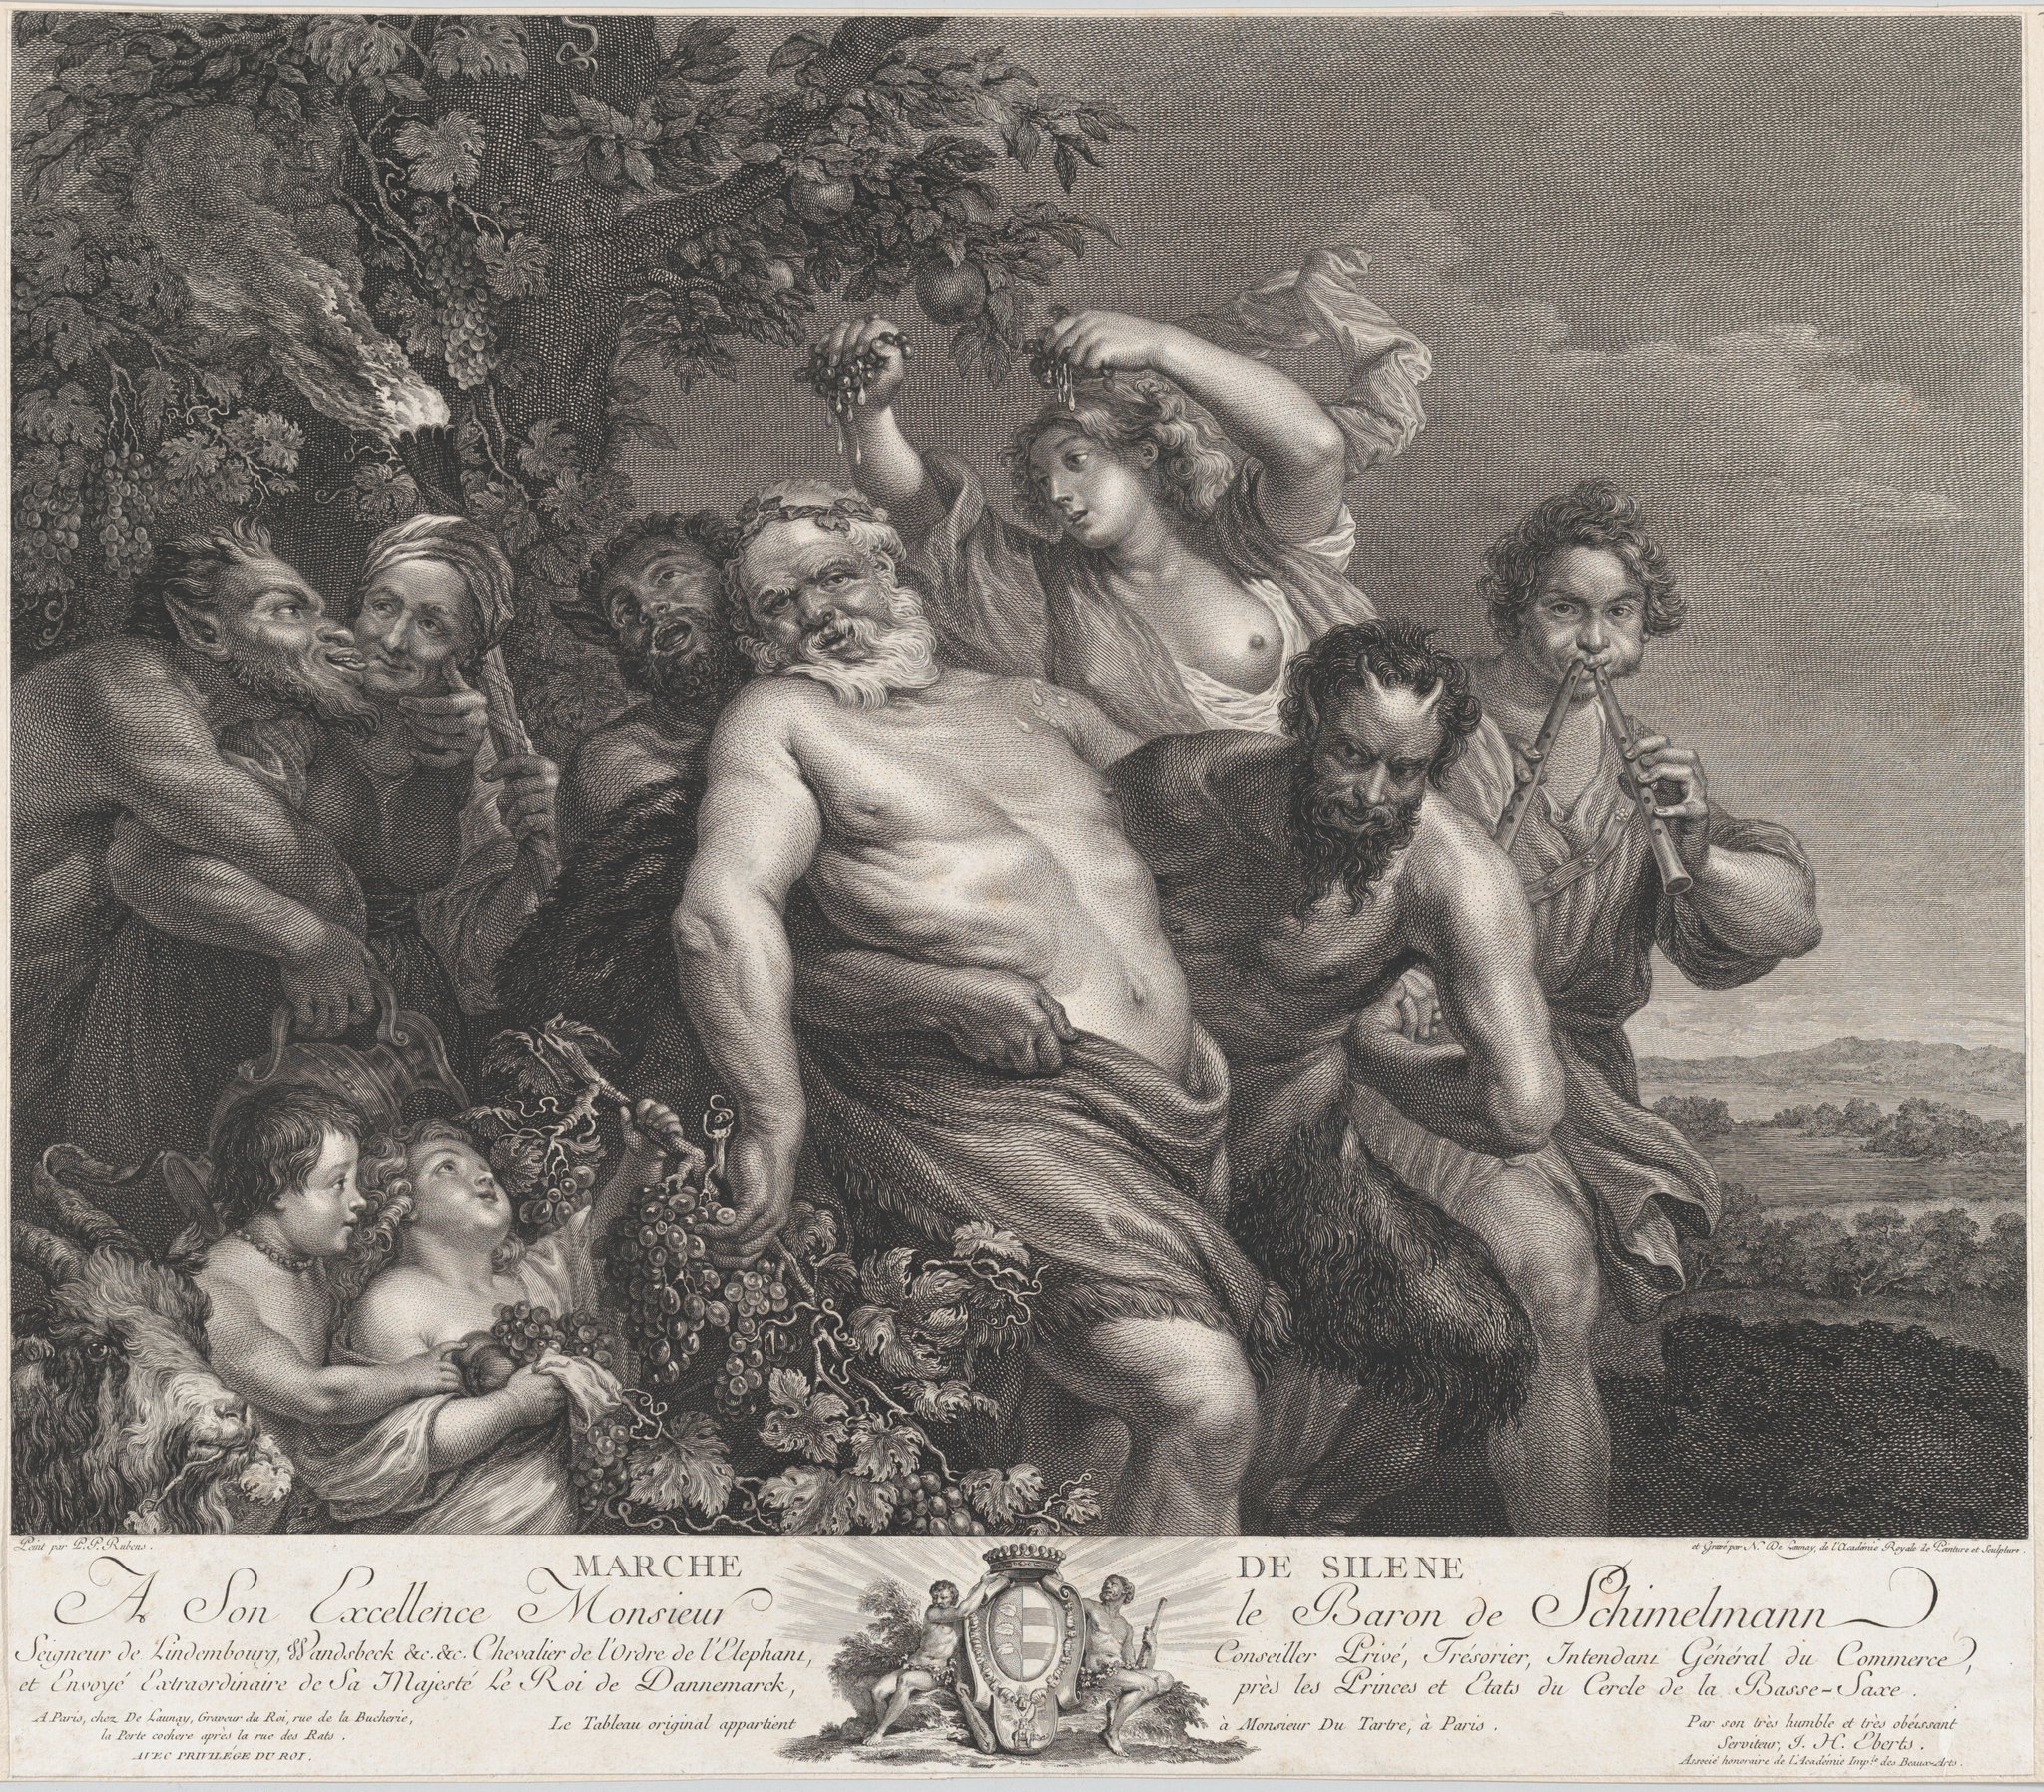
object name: print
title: The Triumph of Silenus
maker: nicolas de launay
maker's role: artist and publisher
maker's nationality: french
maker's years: 1739-1792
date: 1775-1778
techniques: engraving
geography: paris